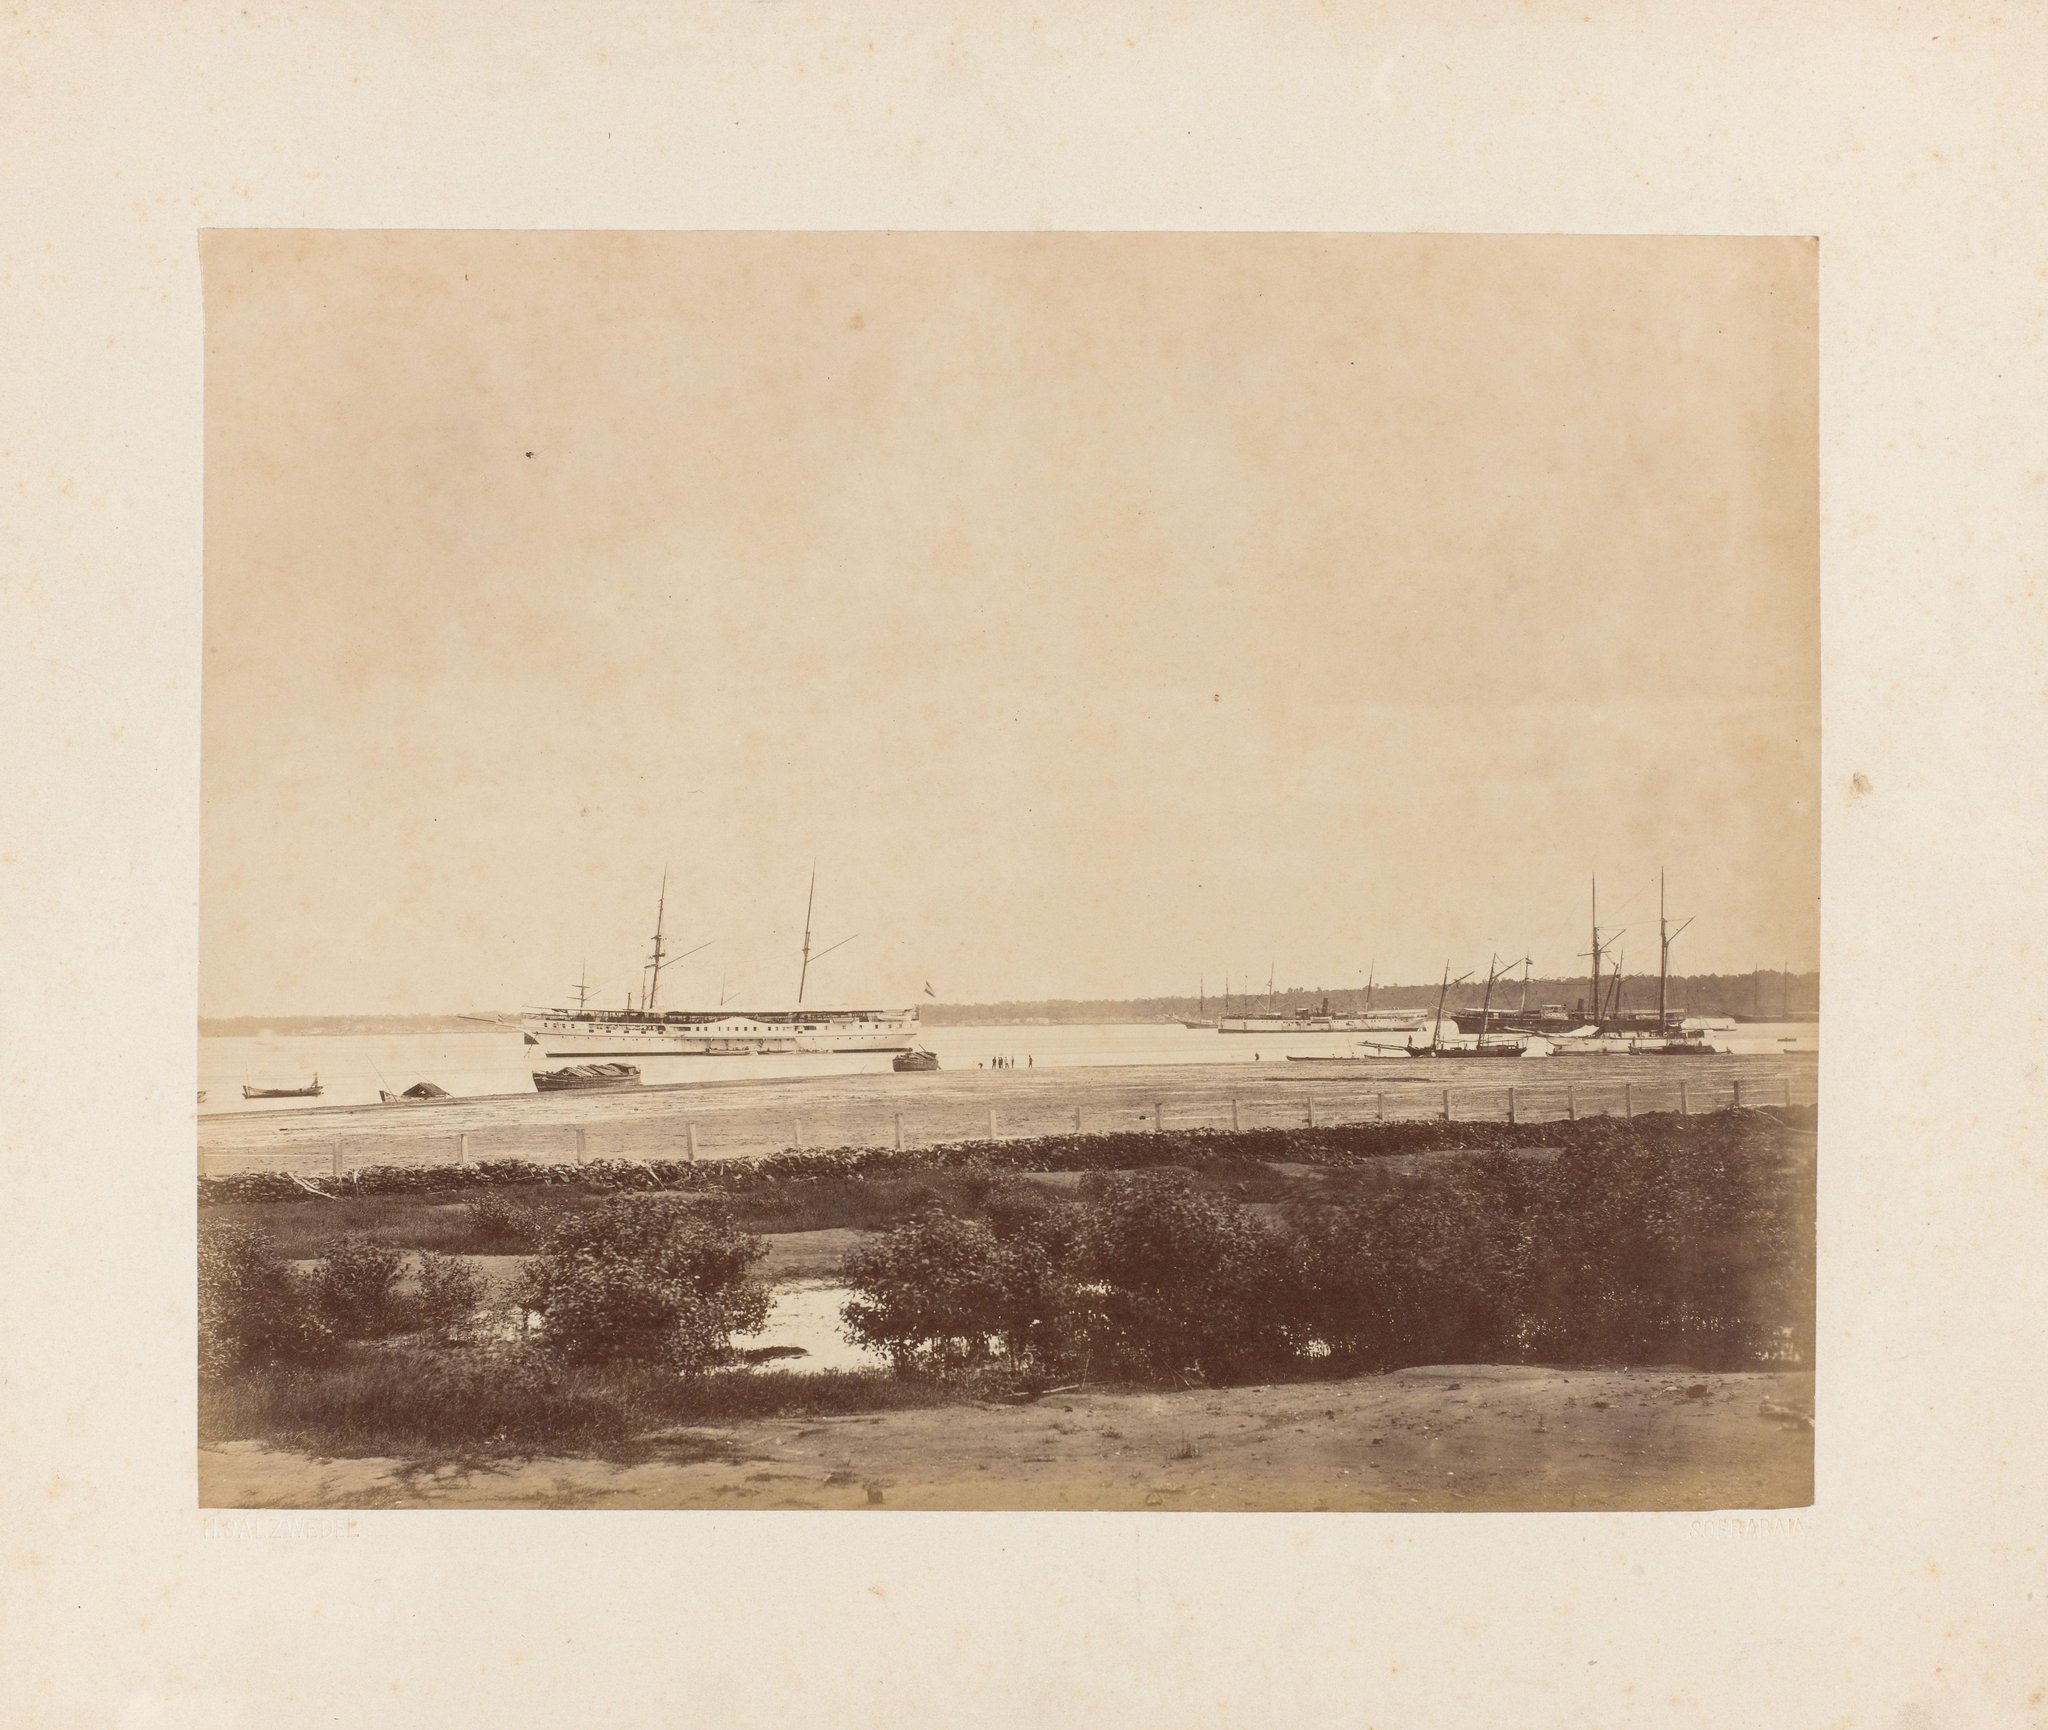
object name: photograph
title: Schepen in een haven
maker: herman salzwedel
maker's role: fotograaf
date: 1880-1888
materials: photographic support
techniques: albumen print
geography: surabaya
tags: java, surabaya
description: Schepen in een haven en aan de kade, waarschijnlijk Tandjong Perak, de haven van Soerabaja. Onderdeel van een groep van 62 foto's in een doos met het opschrift "Staatsspoorwegen op Java" uit 1888.